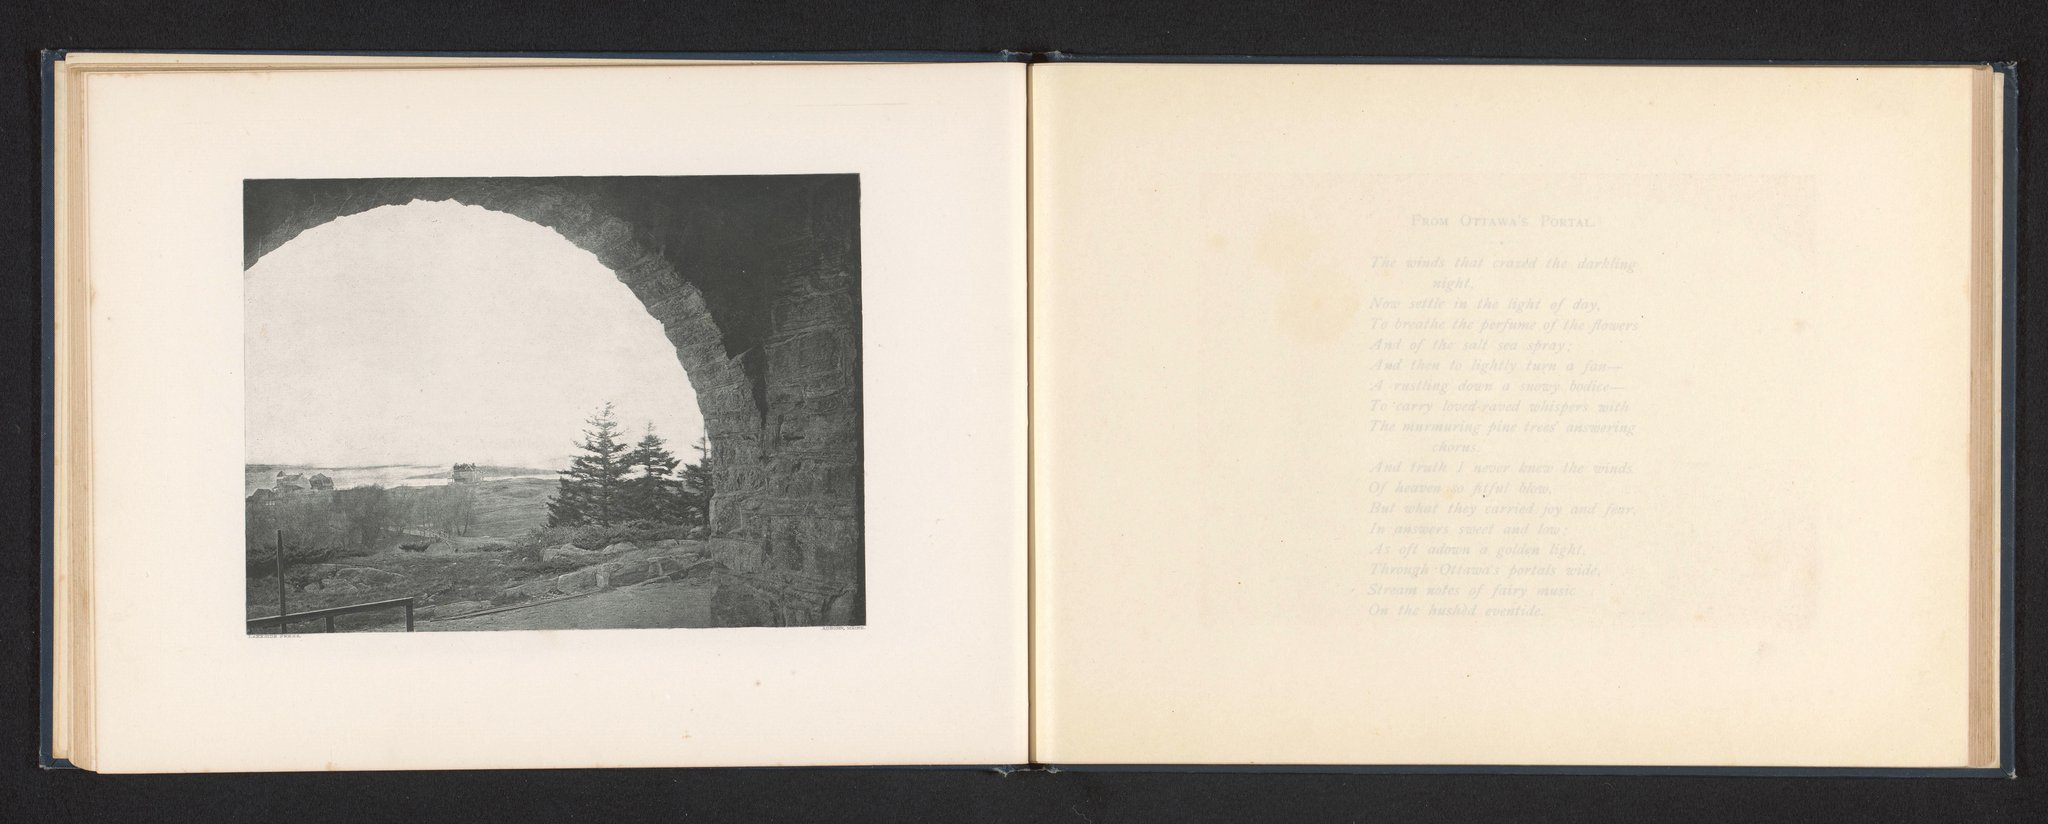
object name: page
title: Kust bij vermoedelijk Maine, gezien door een boog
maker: Anonymous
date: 1880-1890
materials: paper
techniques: photoaquatint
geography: maine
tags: arch, archivolt ~ architecture, coast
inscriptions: inscription: ‘From Ottawa's Portal. (...)’